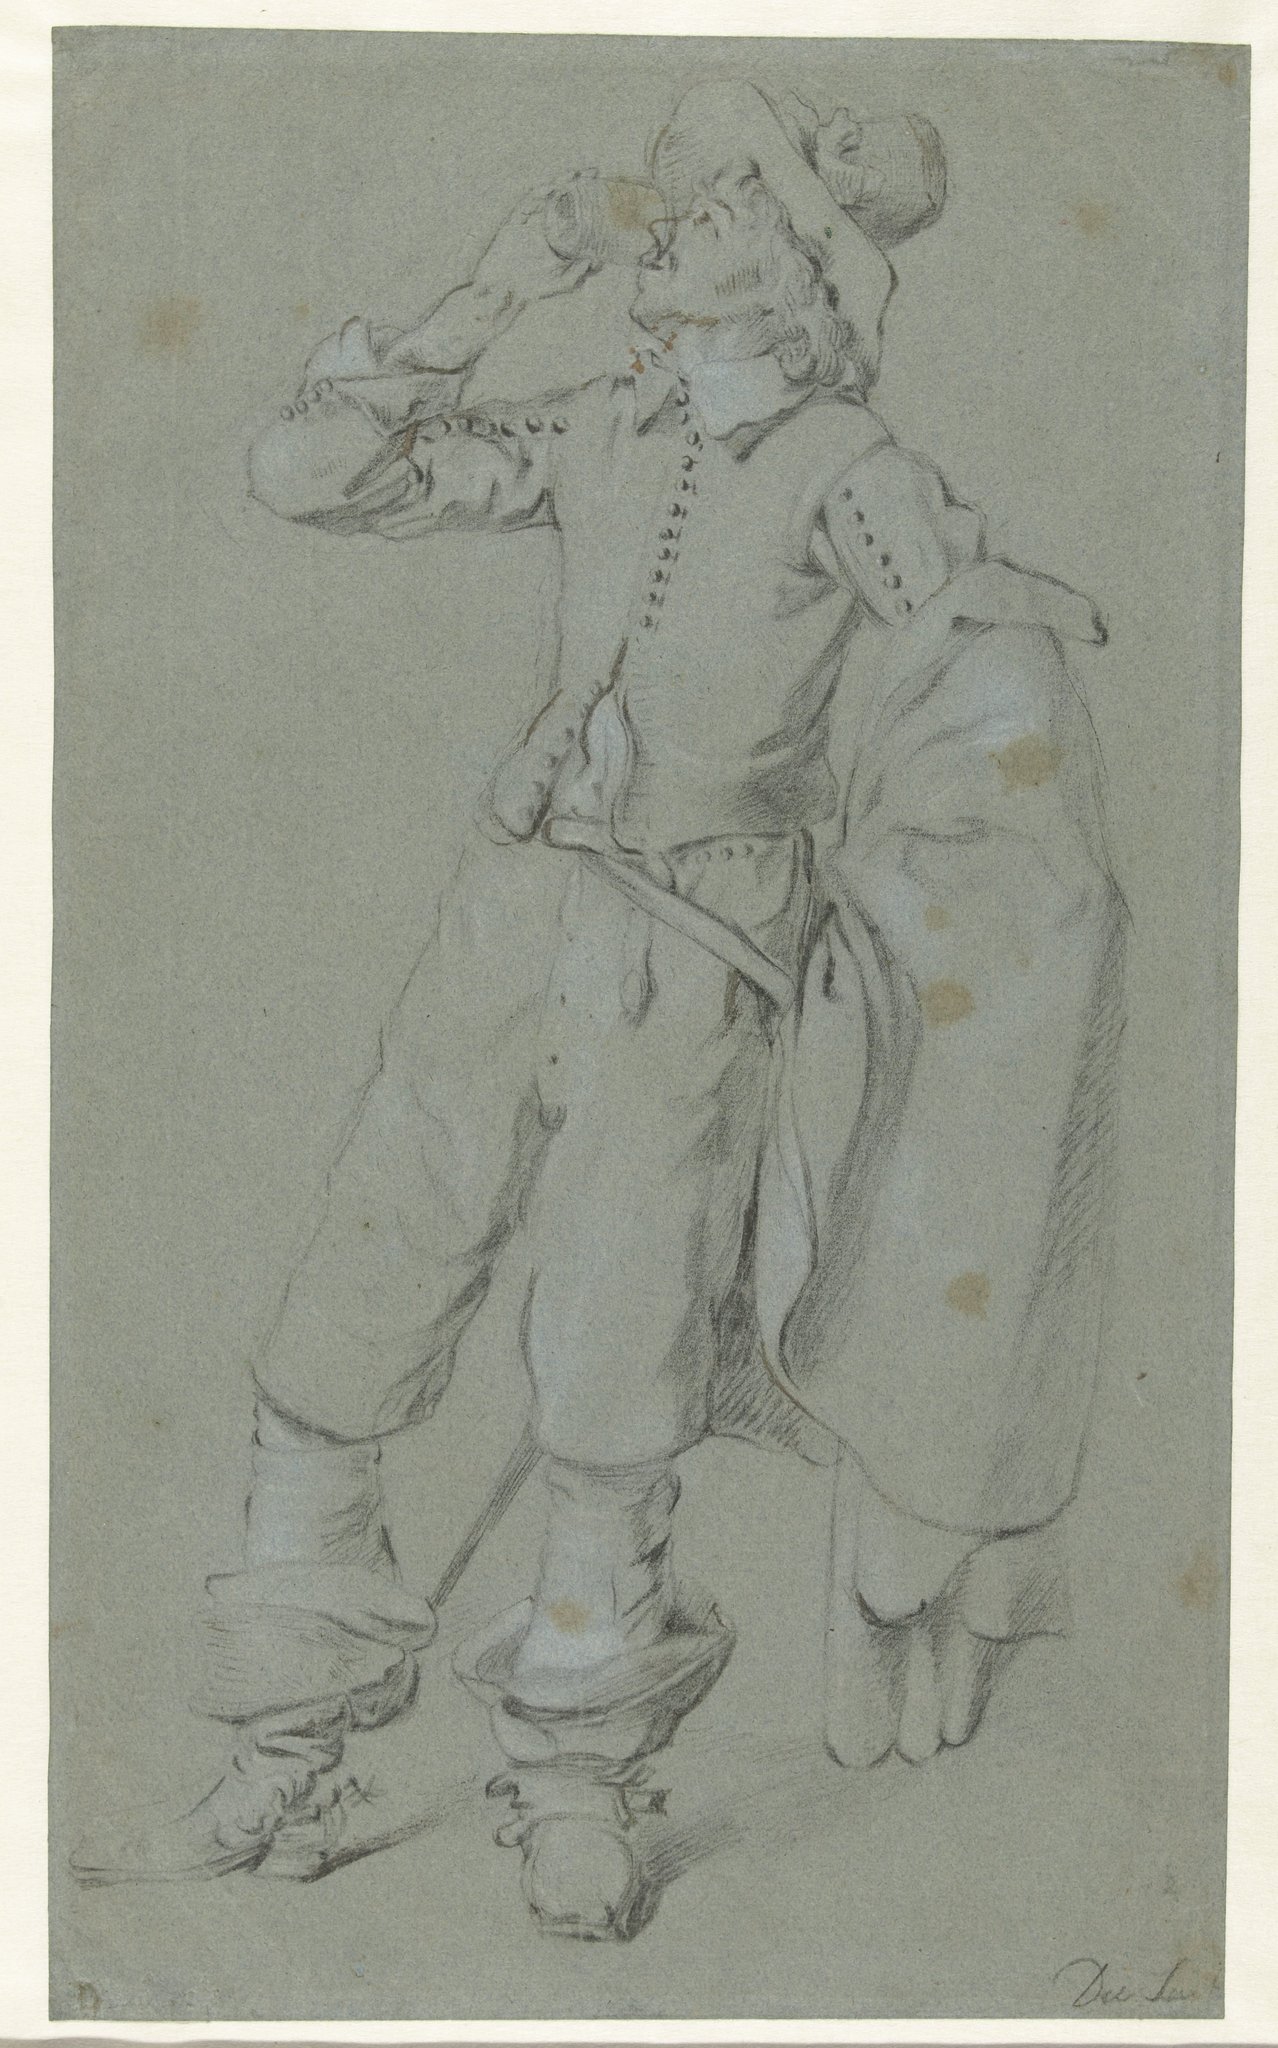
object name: drawing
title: Drinkende man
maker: lambert doomer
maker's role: draughtsman, painter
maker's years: 1622-1700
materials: chalk, ink, paper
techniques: pen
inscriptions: annotation: ‘D[usar]t (grotendeels uitgewist (l.o.); Du Sart (r.o.)’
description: studie voor de man op een gesigneerd en 1676 gedateerd schilderij met onbekende verblijfplaats (Bulletin v/h Rijksmuseum 2002, pp. )